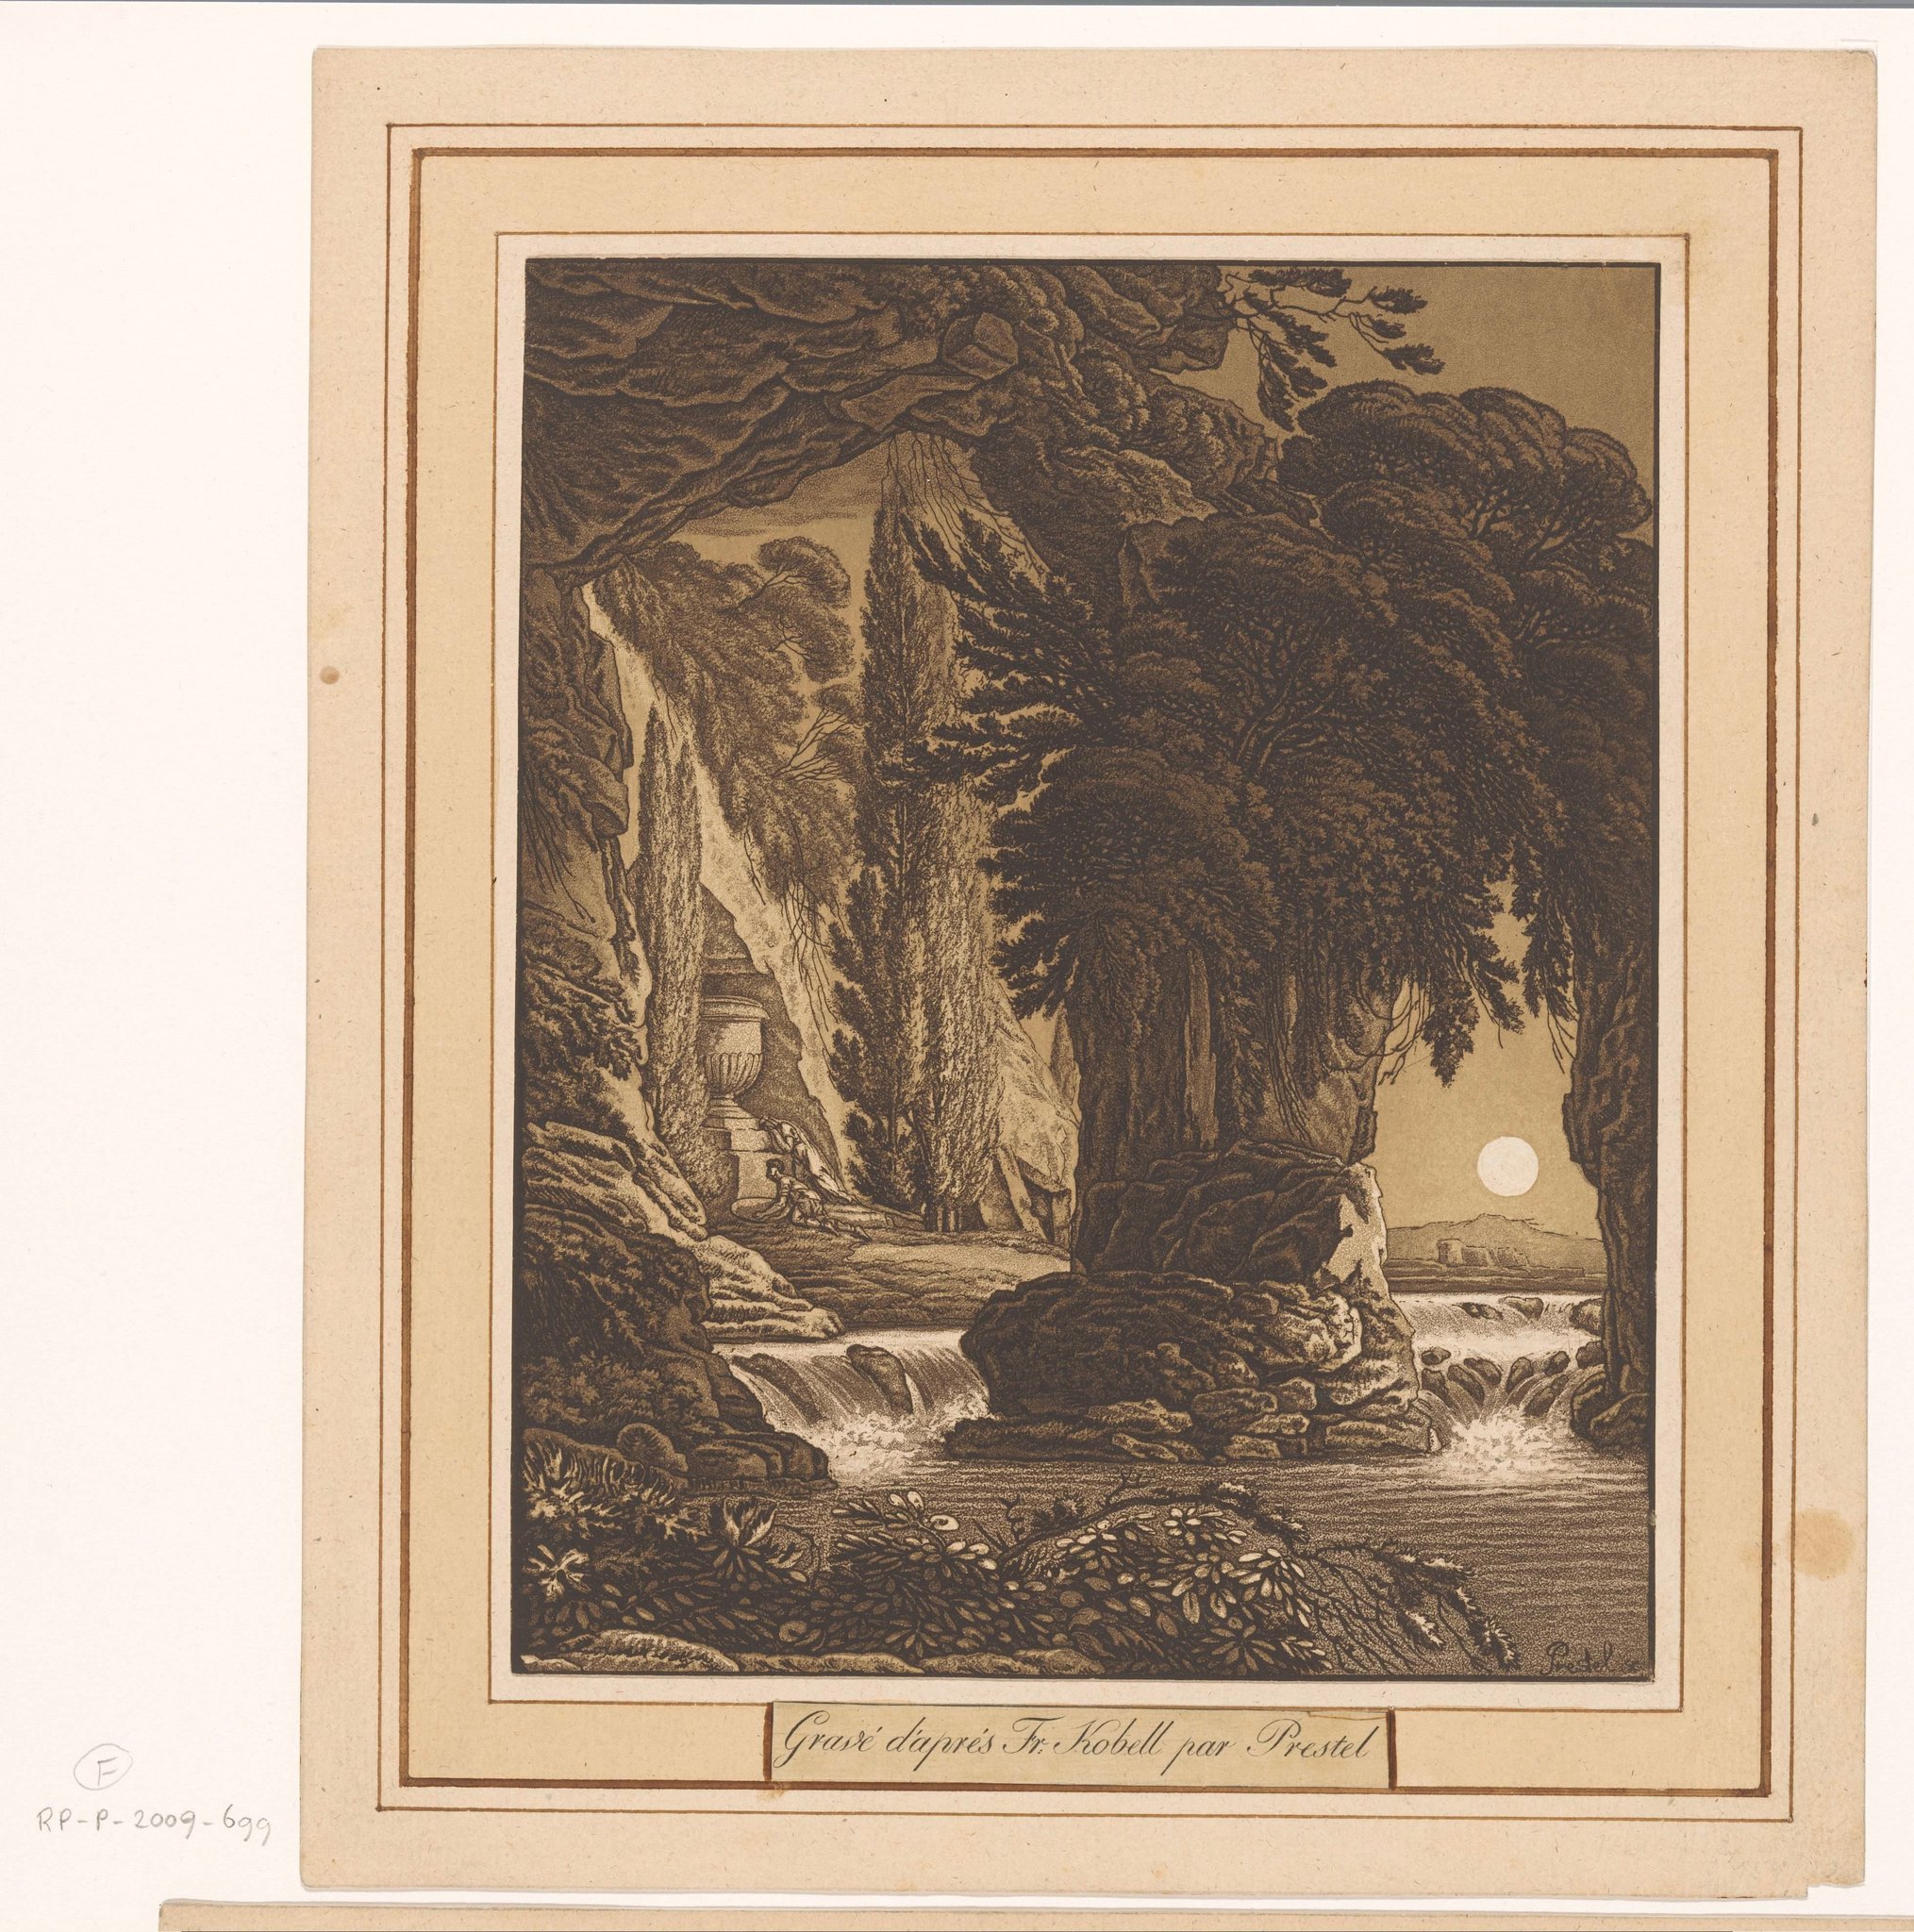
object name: print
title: Rotsachtig landschap met een waterval, links twee rouwende figuren voor een grafmonument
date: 1791-1819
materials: paper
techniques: aquatint, etching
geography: mannheim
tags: waterfall, grave, tomb and other grave-forms and grave-markers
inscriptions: collector's mark: Lugt 2228, collector's mark: Lugt 2760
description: Afkomstig uit een serie van twaalf landschappen naar ontwerp van Ferdinand, Franz en Wilhelm Kobell, in prent gebracht door verschillende prentmakers, uitgegeven door Domenico Artaria in Mannheim.